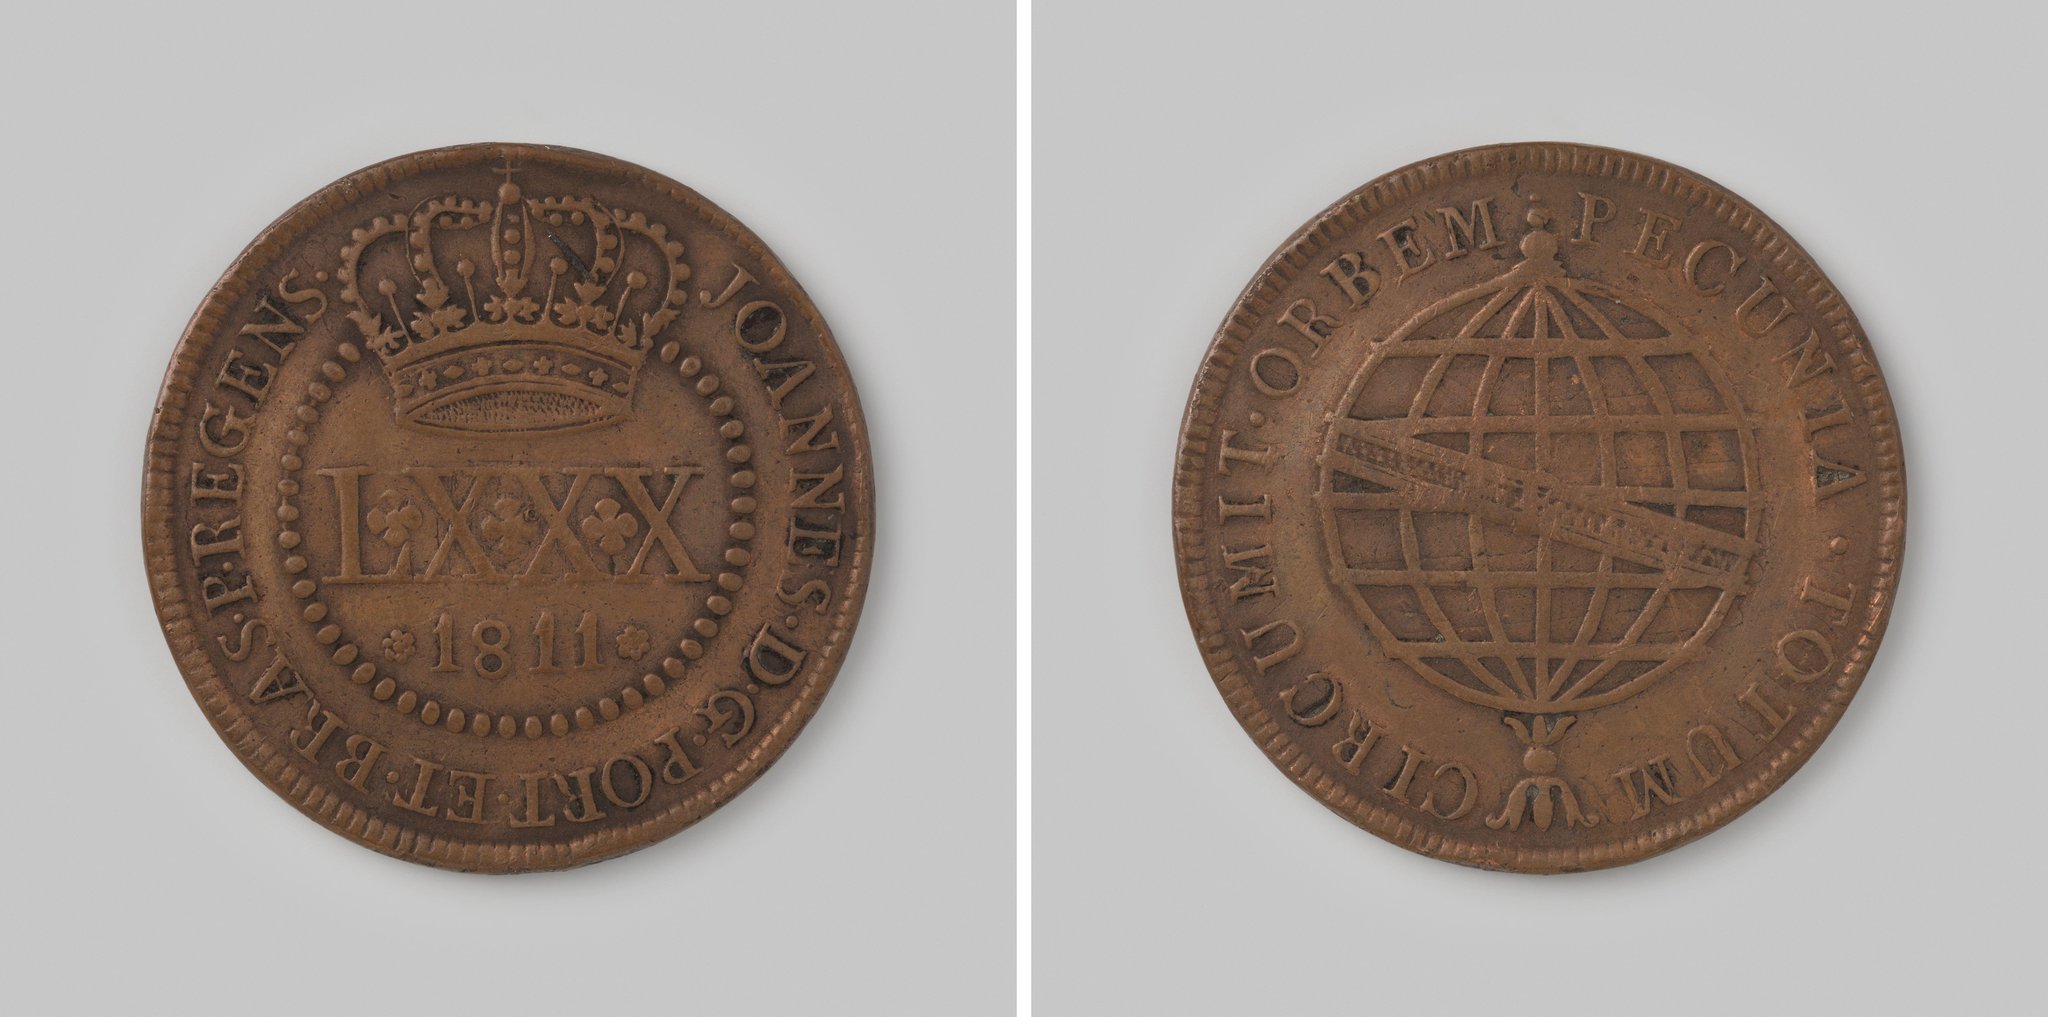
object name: coin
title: 4 vintens of 80 reis uit Brazilië voor Goias en Mato Grosso van prins-regent Joao VI, 1811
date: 1811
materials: copper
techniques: striking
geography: rio de janeiro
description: Koperen munt. Voorzijde: onder kroon waarde-aanduiding: LXXX. Daaronder jaartal. Keerzijde: wereldbol, waaromheen lint, rondom verticale as op voetstuk. Gladde rand.